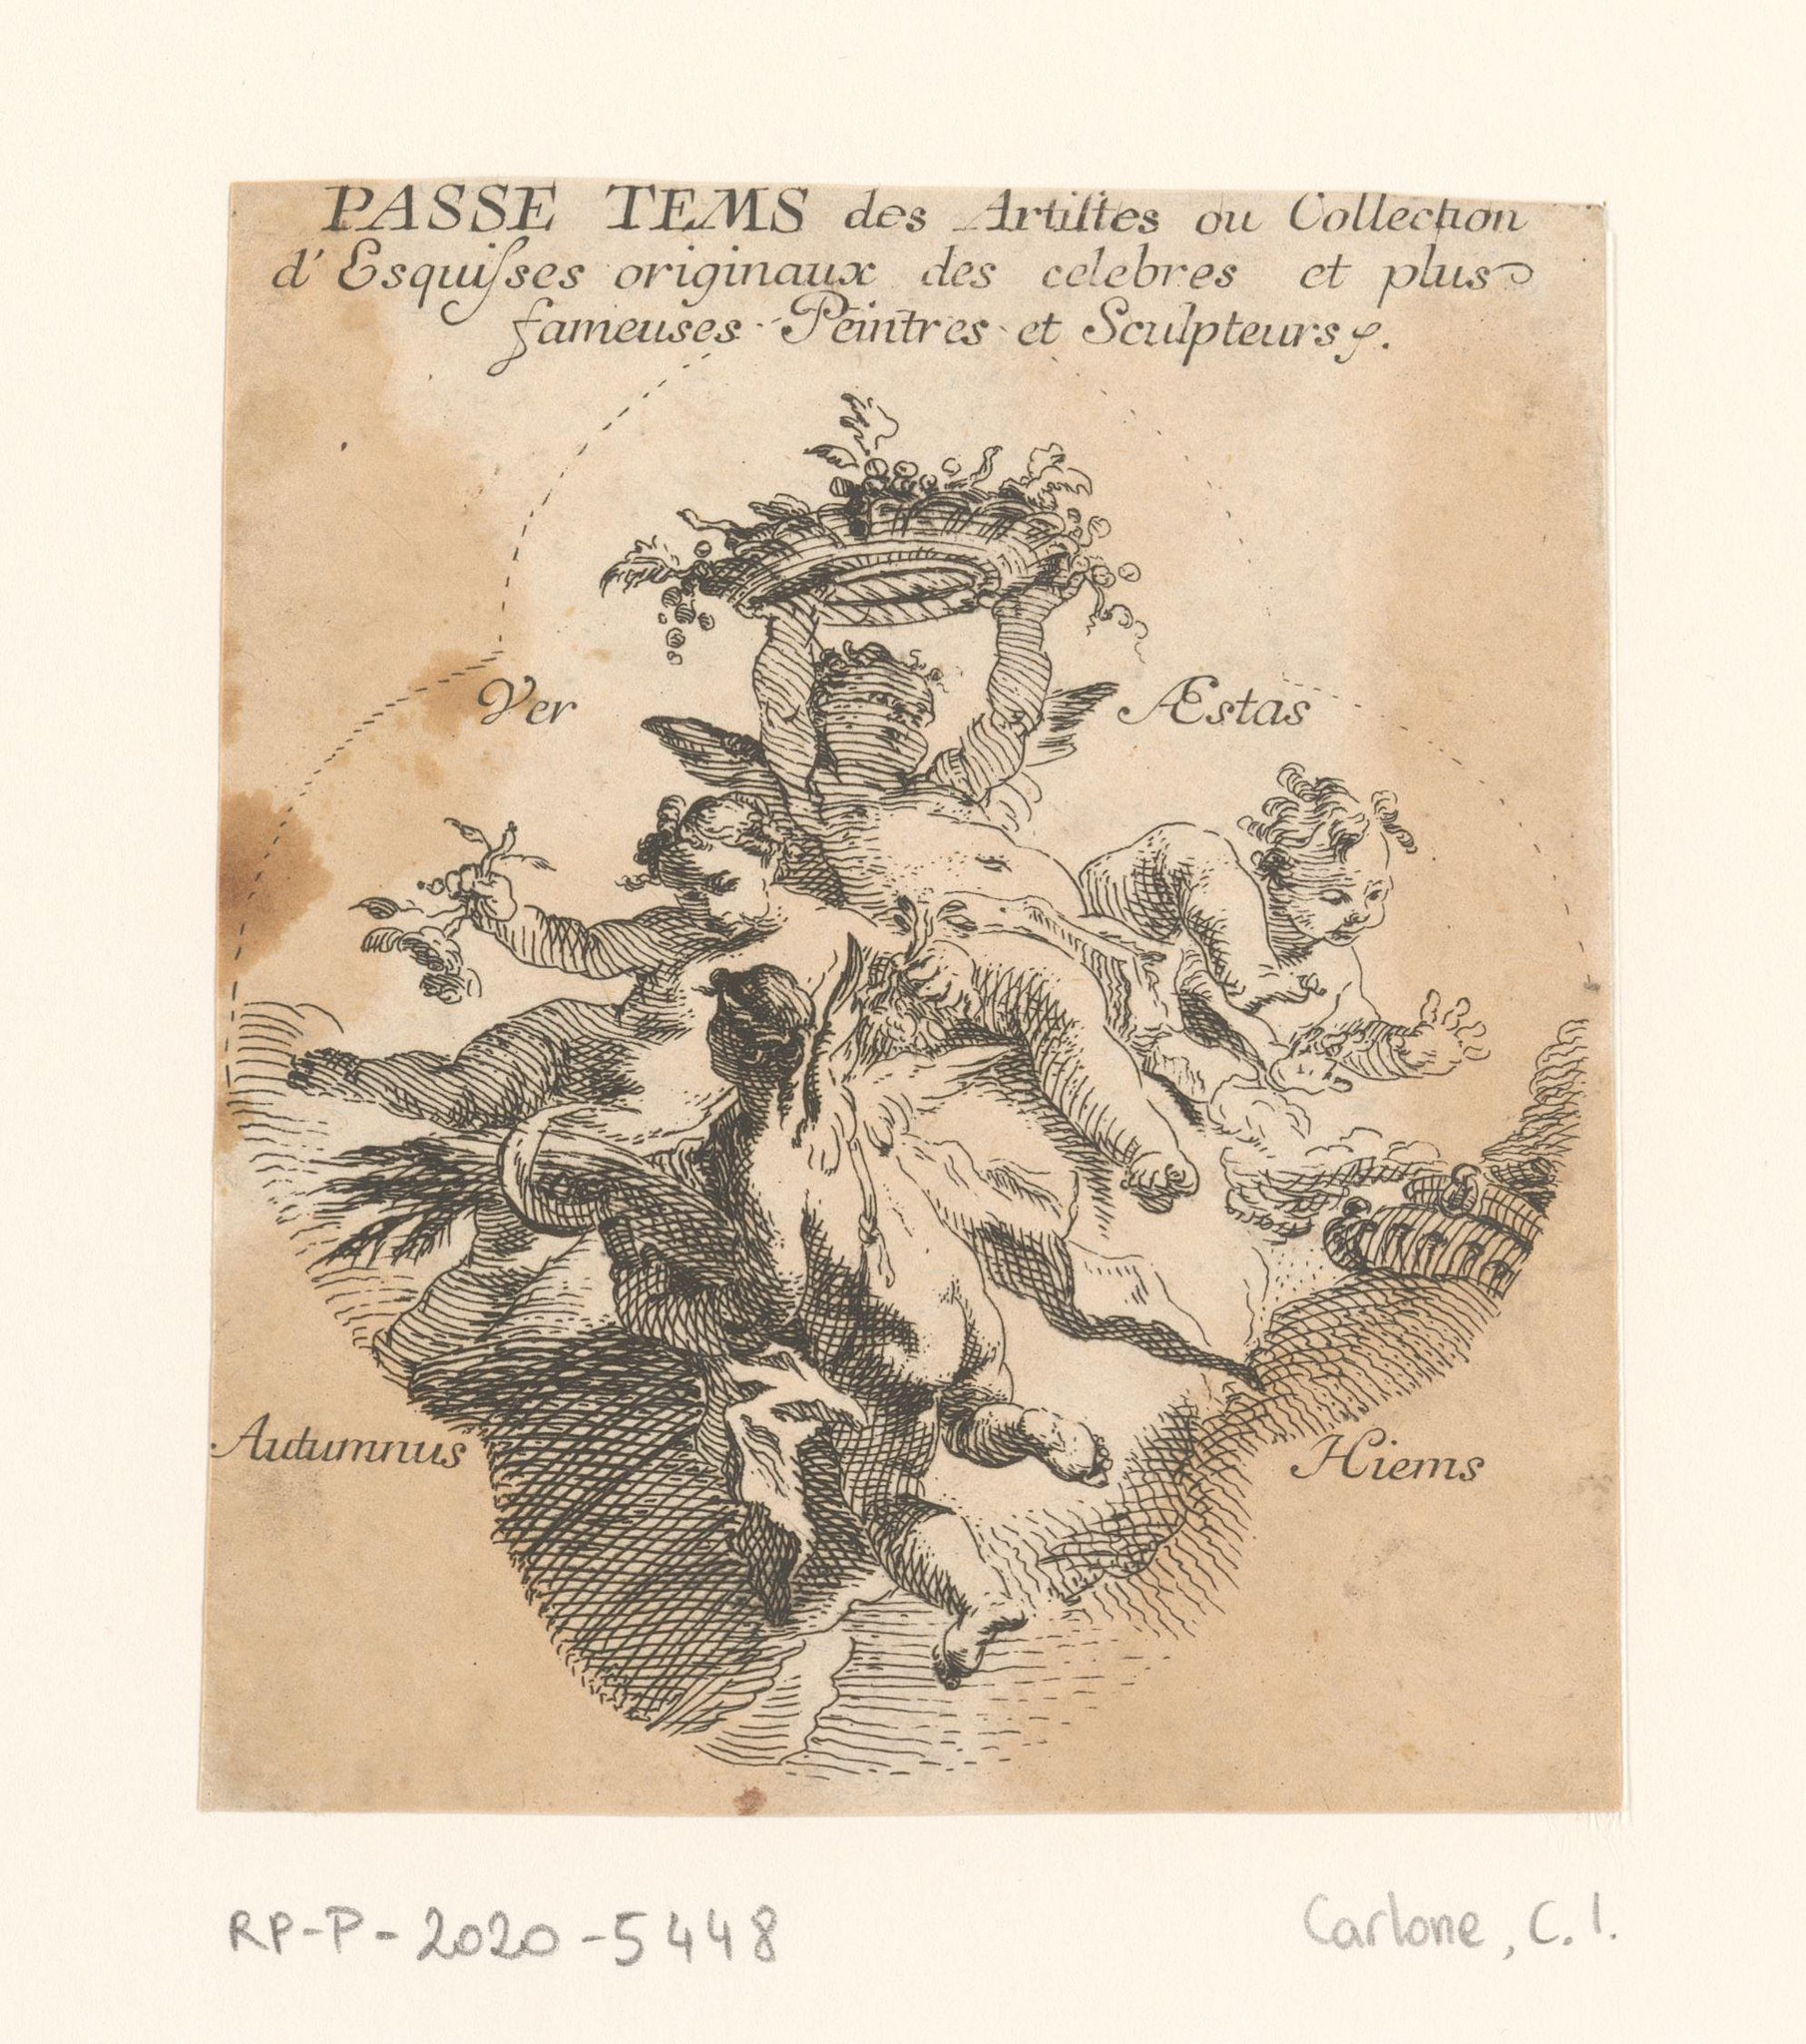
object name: print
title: Passe tems des artistes, ou collection d'esquisses originaux des celebres et plus fameuses peintres et sculpteurs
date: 1703-1754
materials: paper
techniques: etching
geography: augsburg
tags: year divided into four seasons, cupids: 'amores', 'amoretti', 'putti'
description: Prent naar een (ontwerp van?) een plafondschildering met vier putti die de vier seizoenen voorstellen.